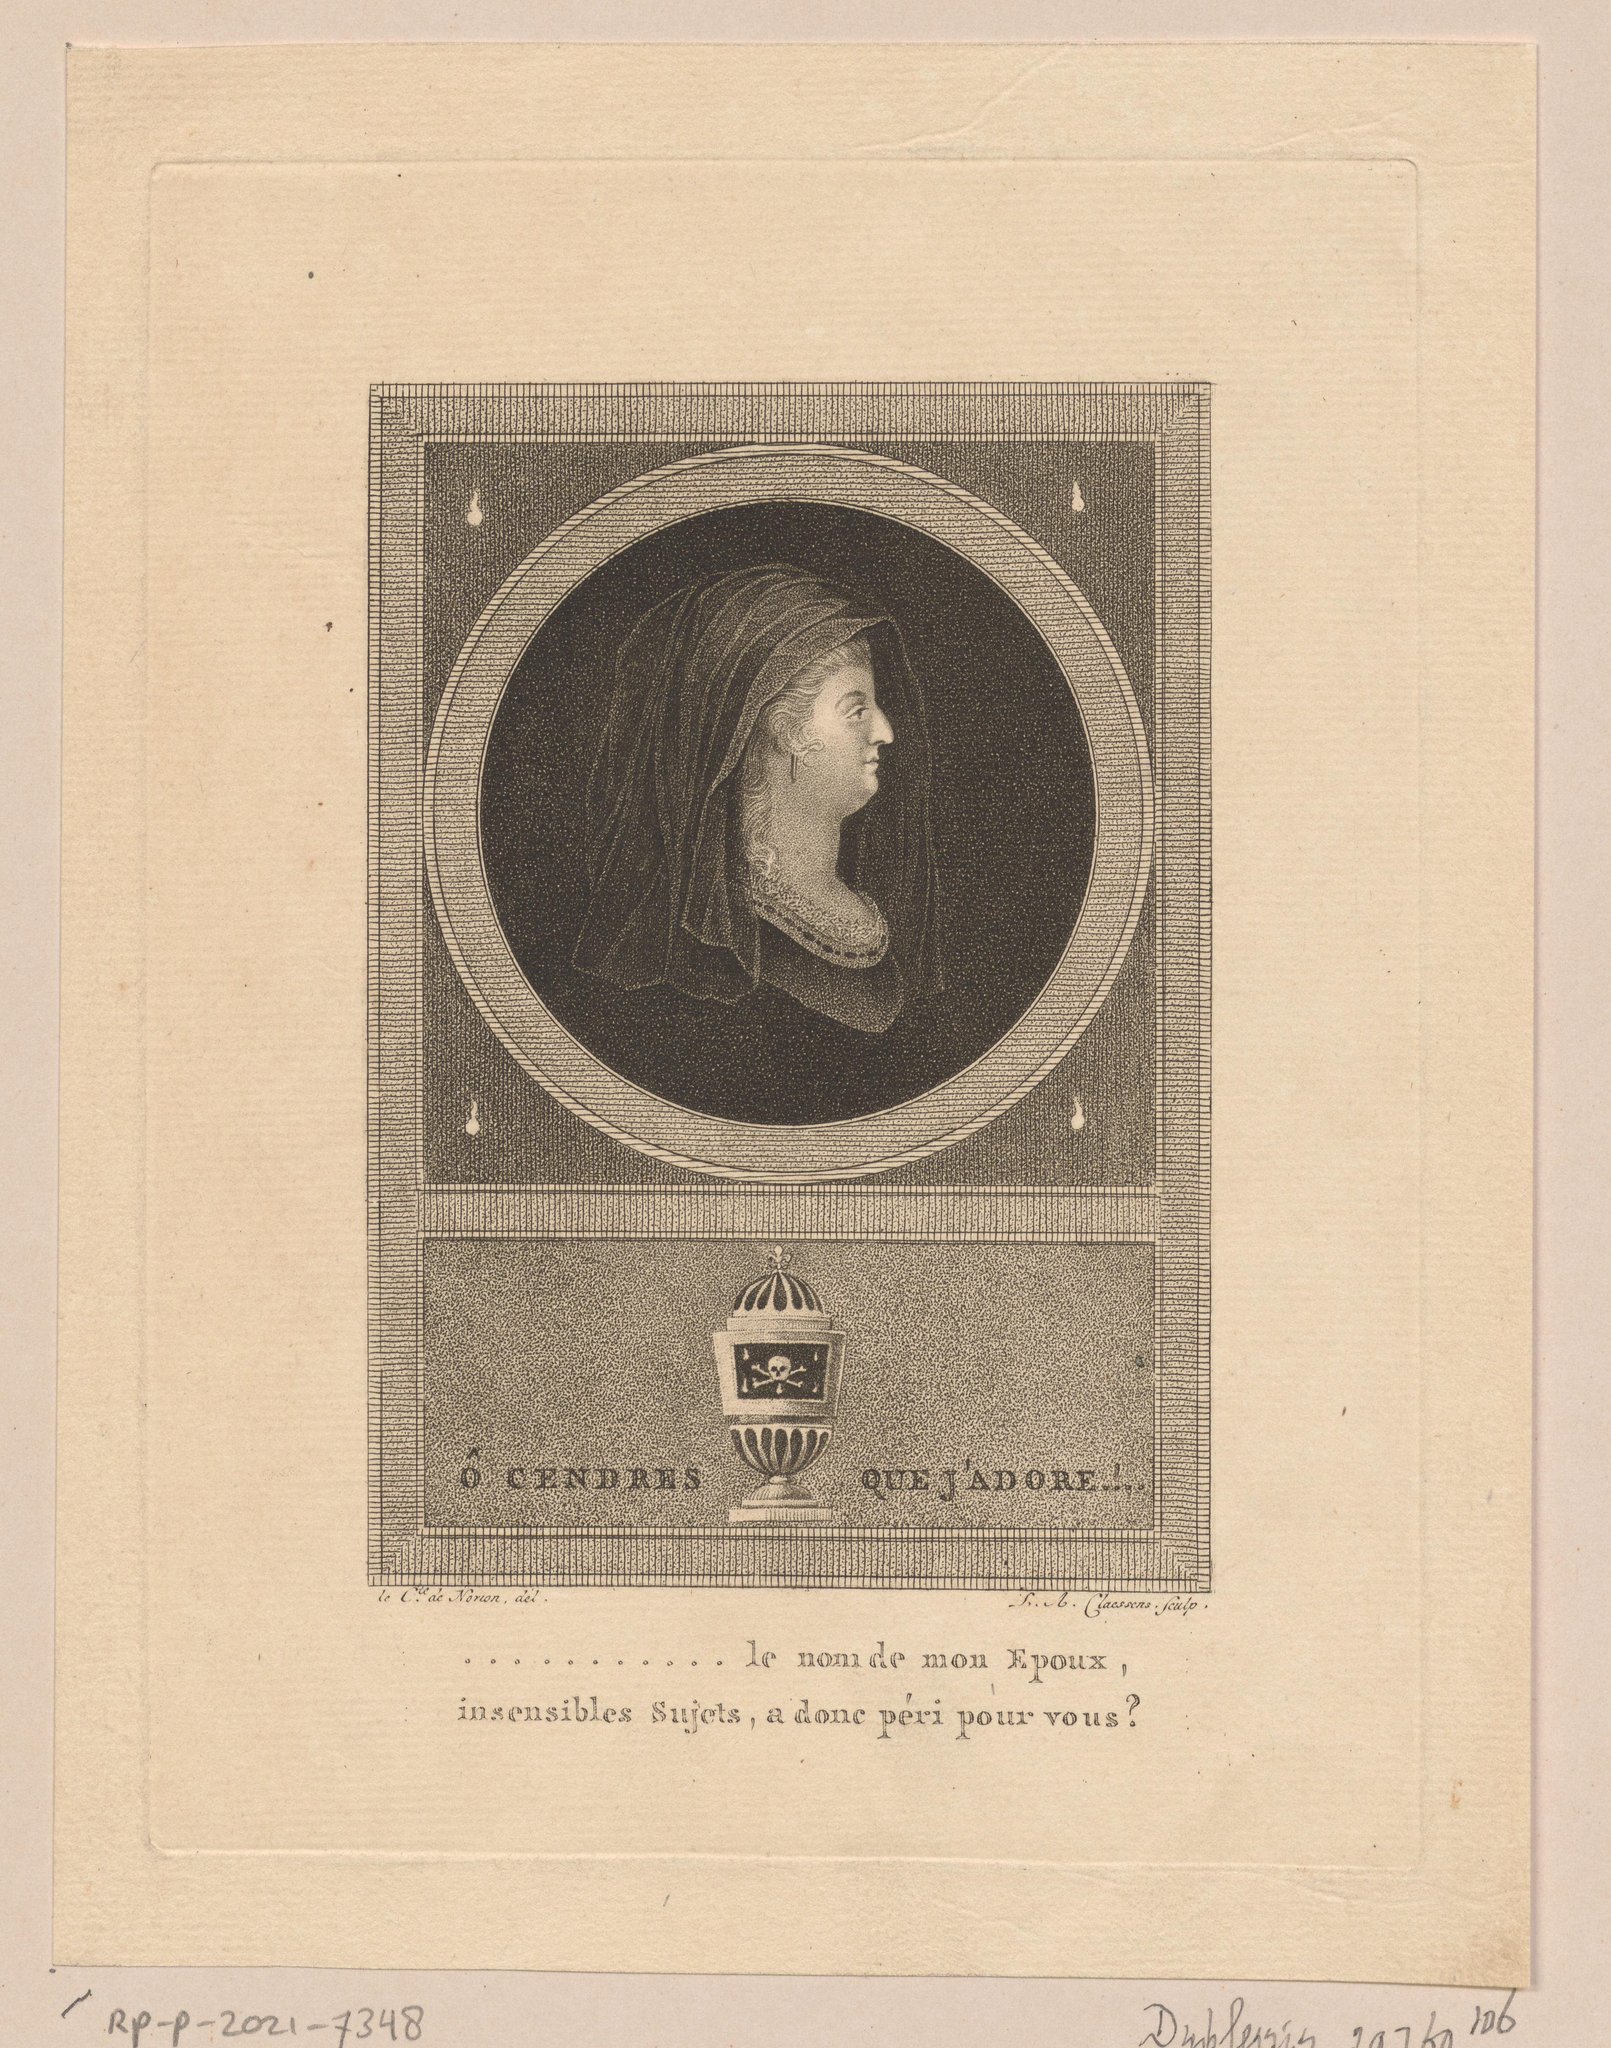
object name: print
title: Memorieportret van Marie Antoinette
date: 1793-1795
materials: paper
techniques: engraving, etching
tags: vienna, paris, marie antoinette, historical persons - bb - woman, queen